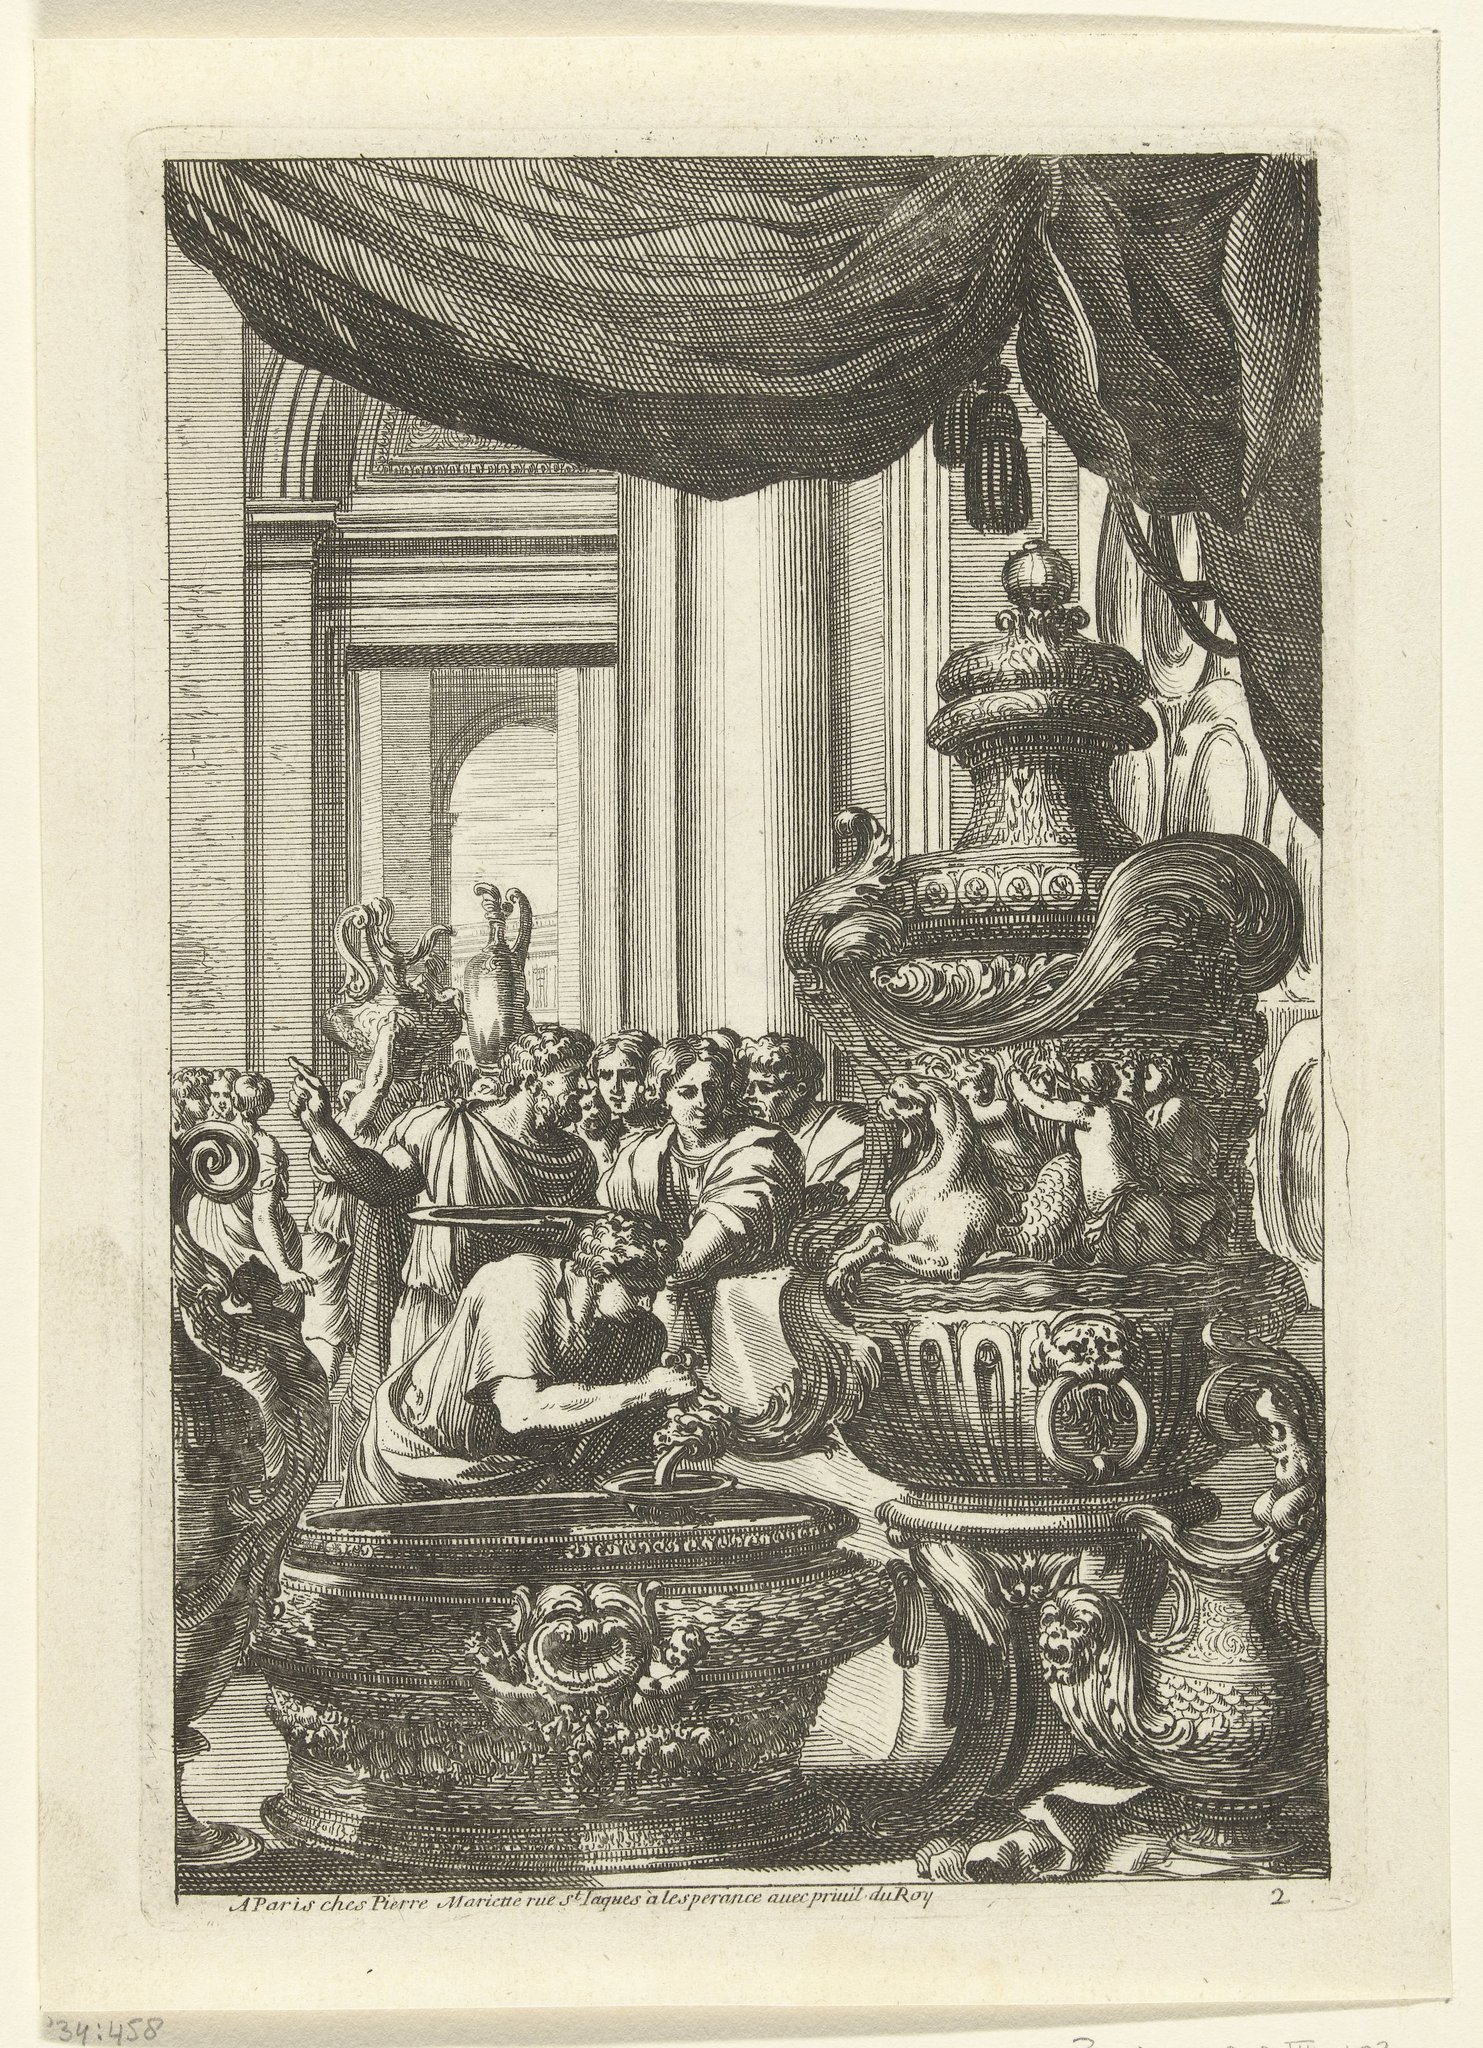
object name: print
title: Fonteines et Cuuettes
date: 1657-1661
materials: paper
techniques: etching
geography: france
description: De fontein is versierd met een fries van putti spelend met een zeemonster, ernaast staan figuren.